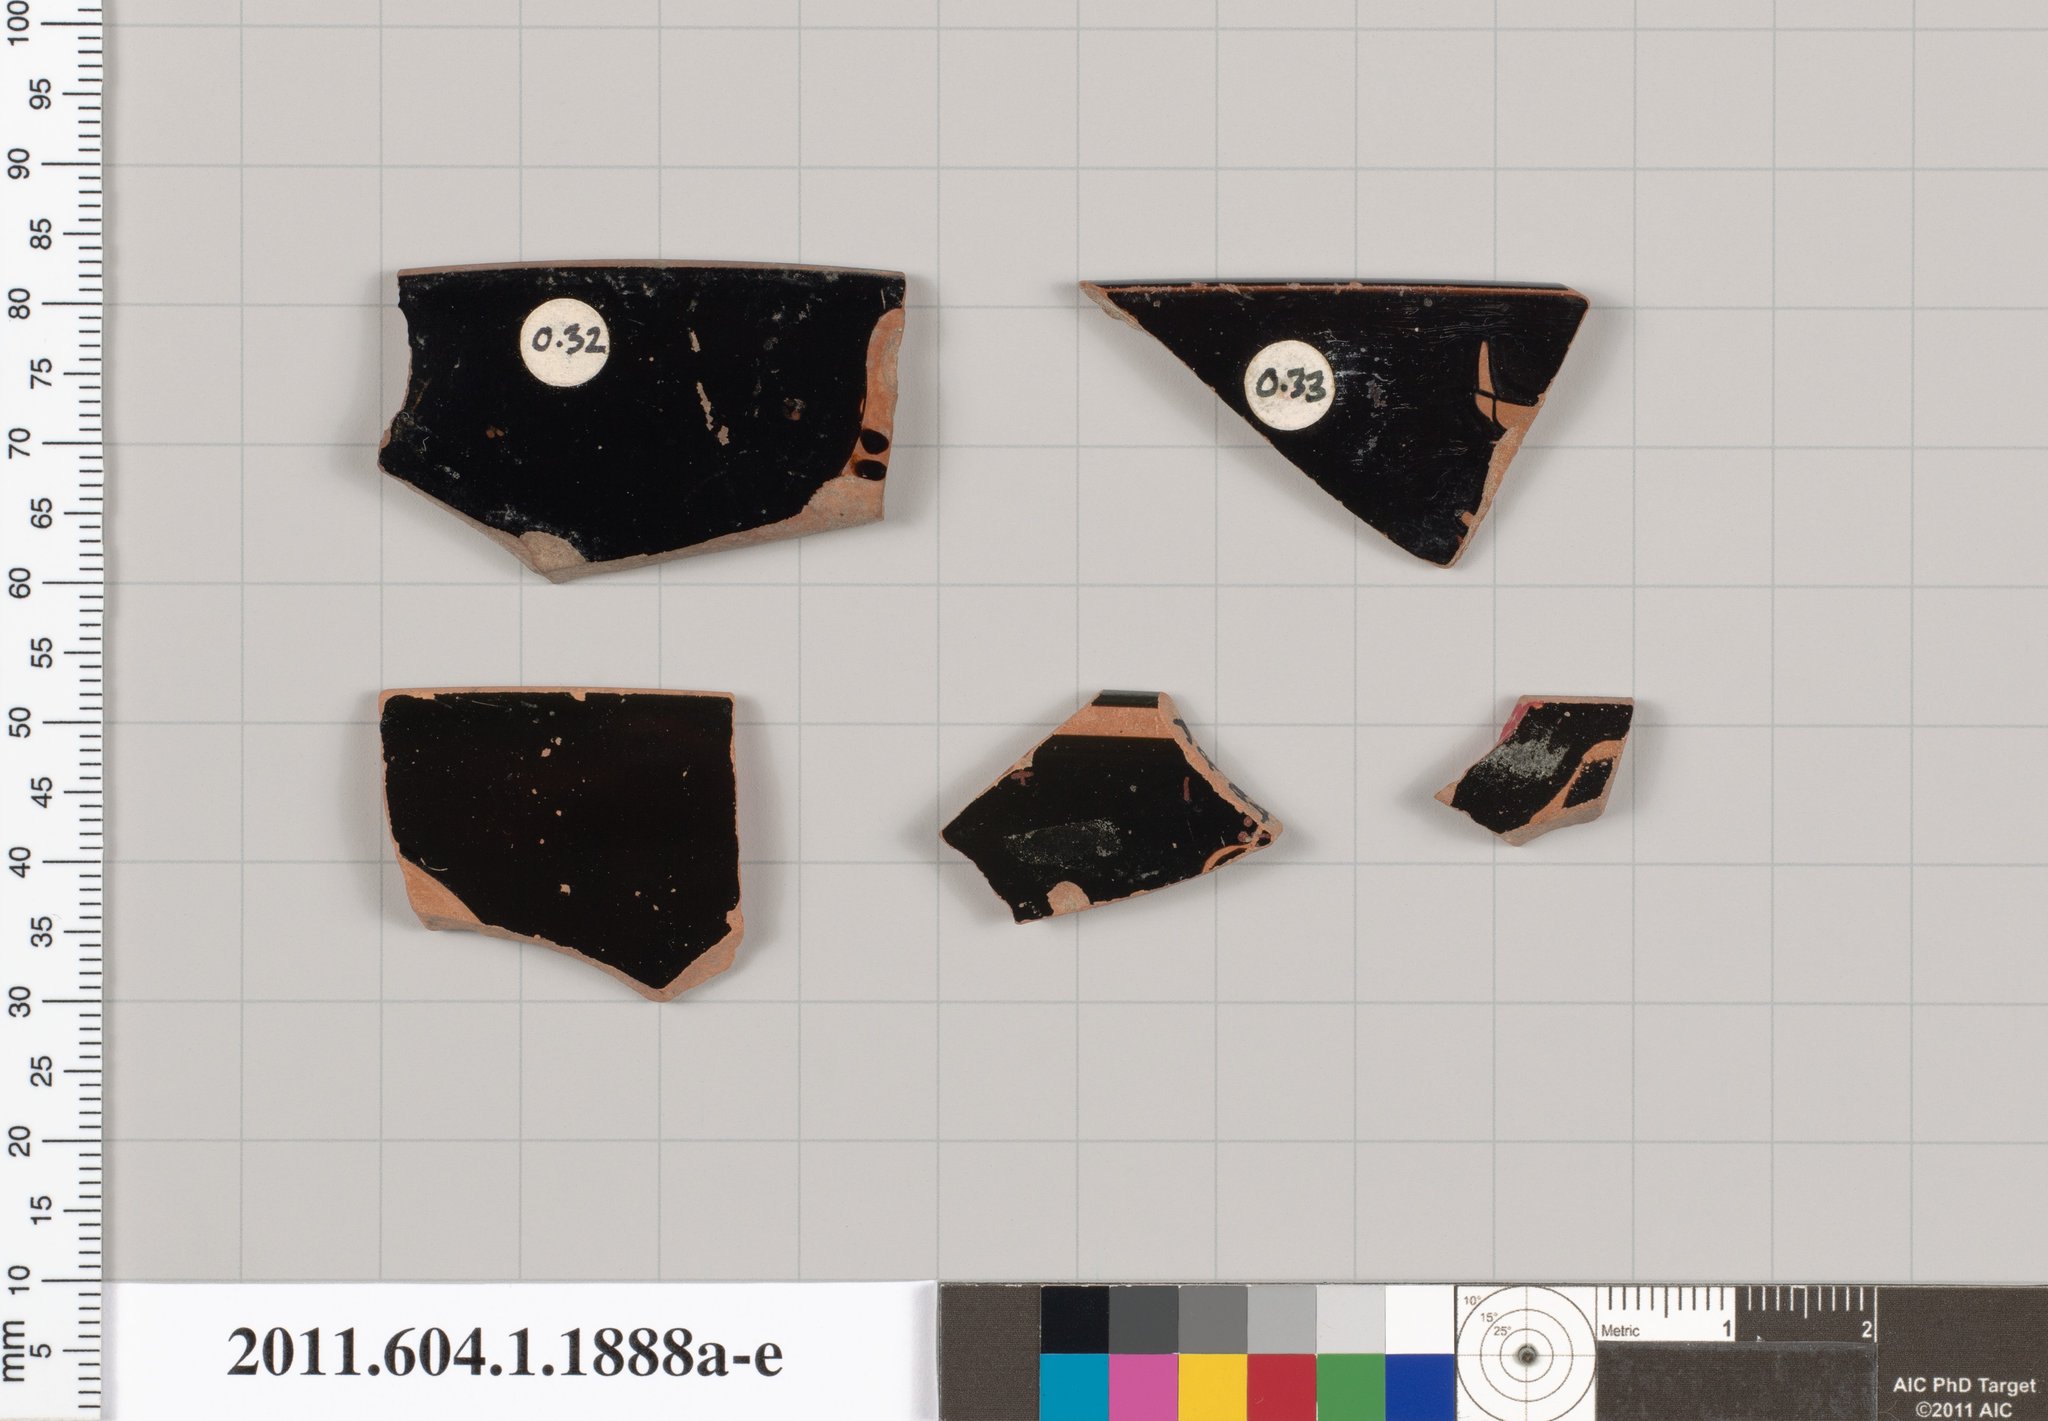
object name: kylix fragment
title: Terracotta rim fragments of kylikes (drinking cups)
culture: greek, attic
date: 500-401 BCE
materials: terracotta